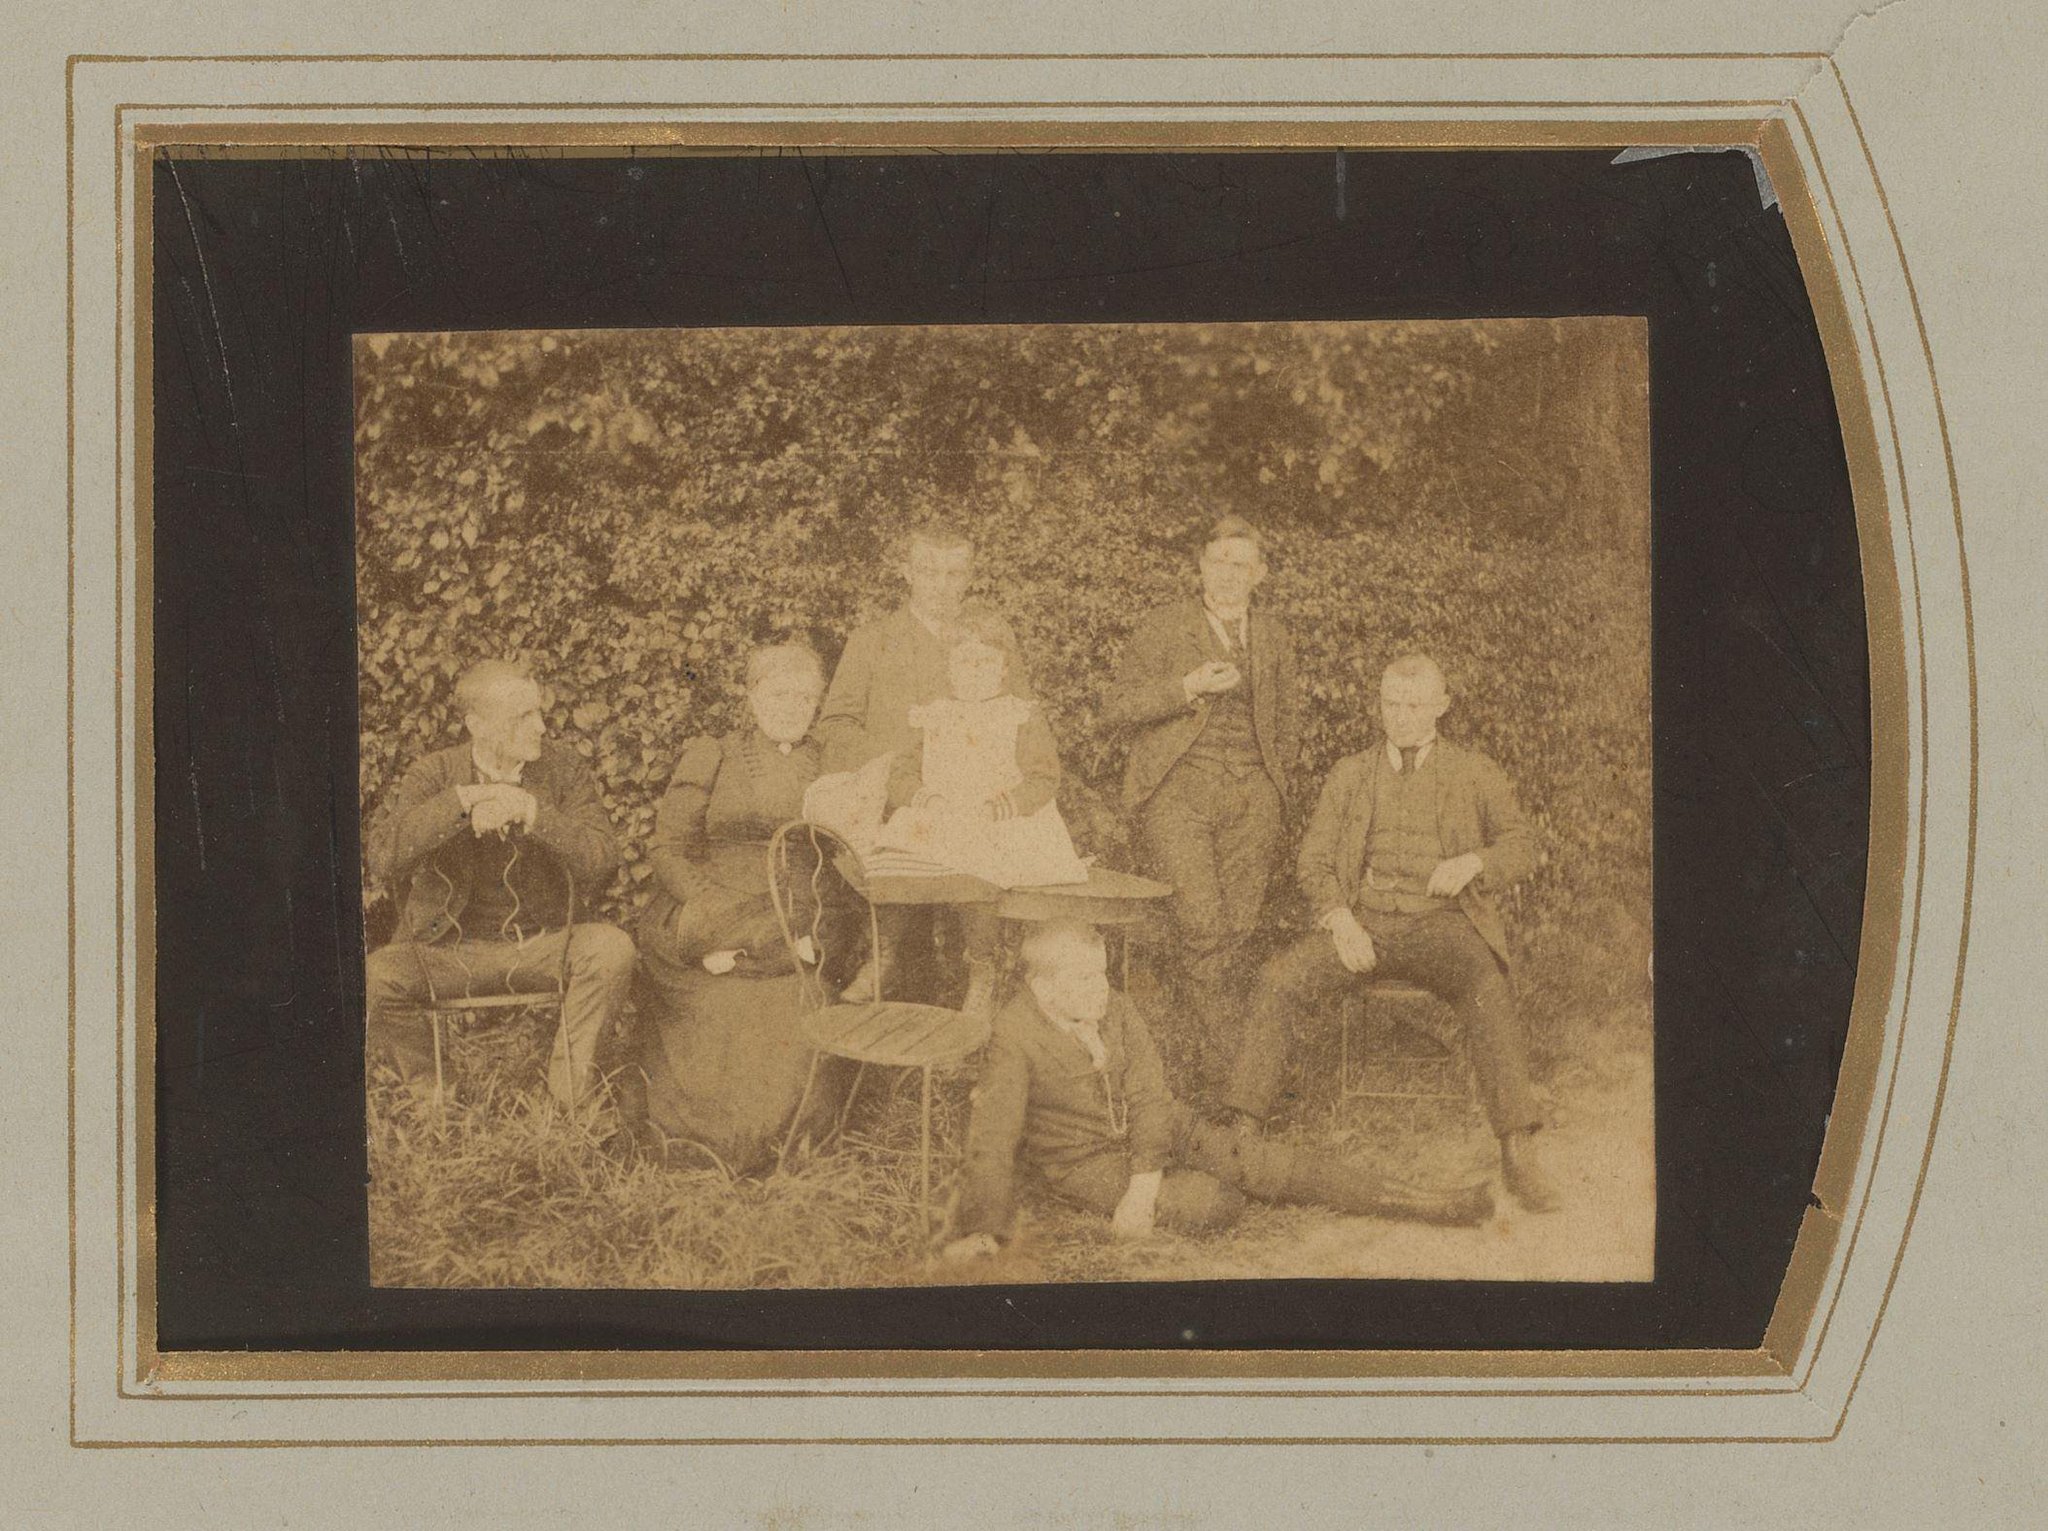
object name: album leaf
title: Groepsportret van vier mannen, een vrouw, een jongen en een meisje, zittend rond een tafel in een tuin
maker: Anonymous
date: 1850-1900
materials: cardboard, photographic support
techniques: albumen print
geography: netherlands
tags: adult woman, boy (child between toddler and youth), garden, adult man (+ four persons), table, toddler (female), anonymous historical persons portrayed in a group, in a group-portrait